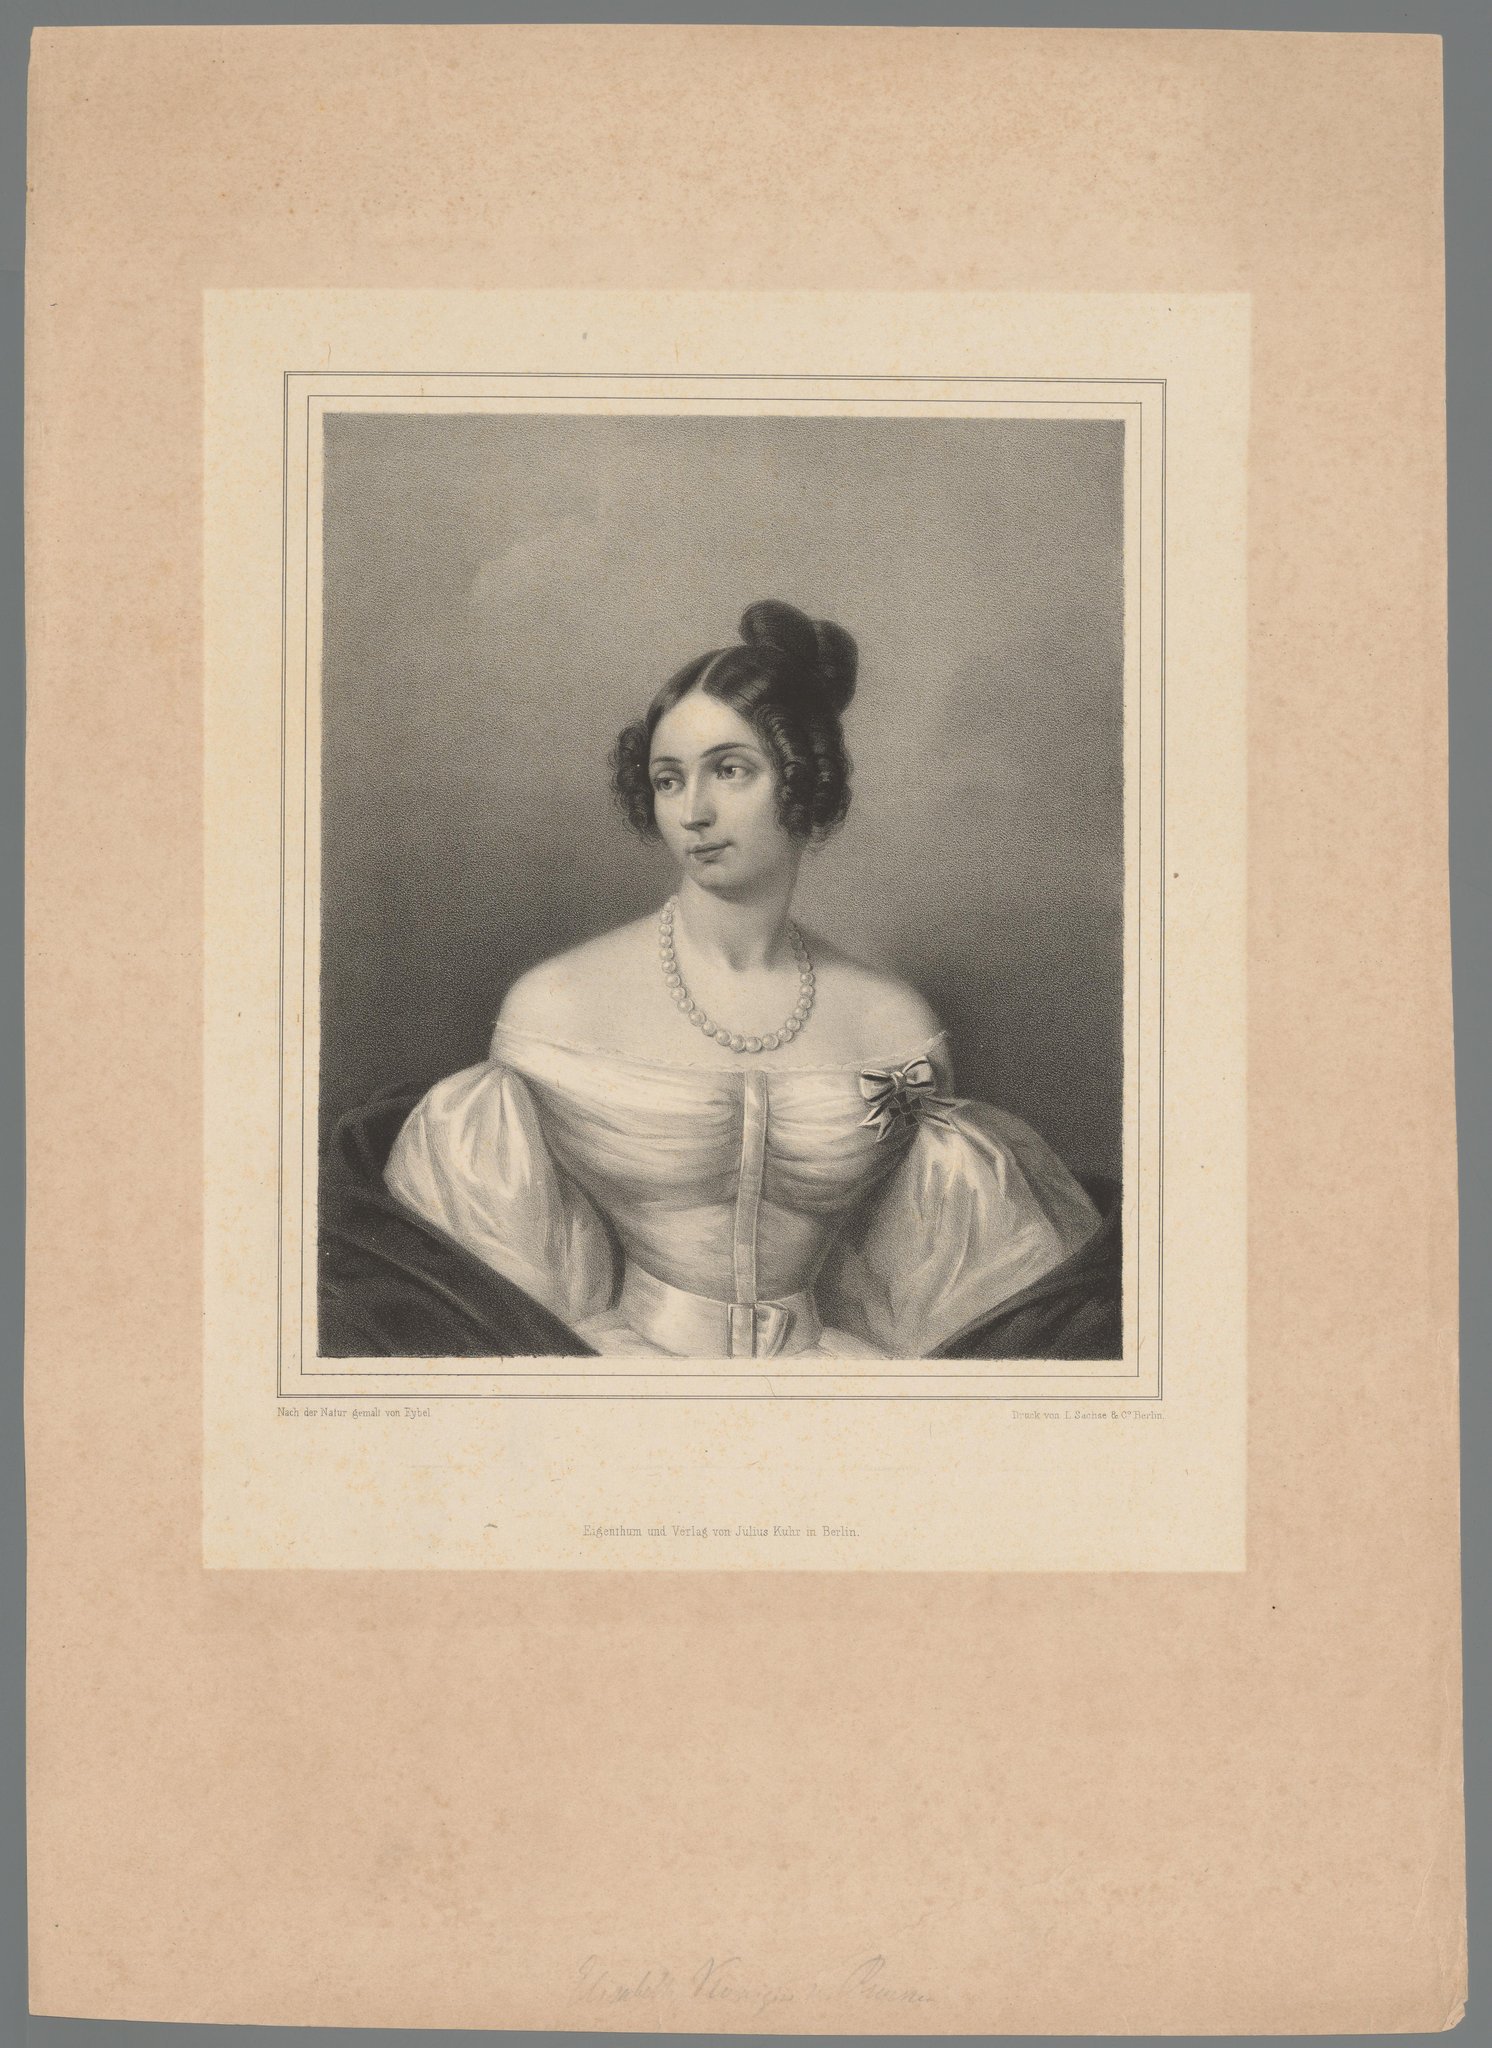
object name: print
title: Portret van Elisabeth van Beieren, koningin van Pruisen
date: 1832-1854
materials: paper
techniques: lithograph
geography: berlin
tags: adult woman, historical persons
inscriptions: collector's mark: Lugt 2228